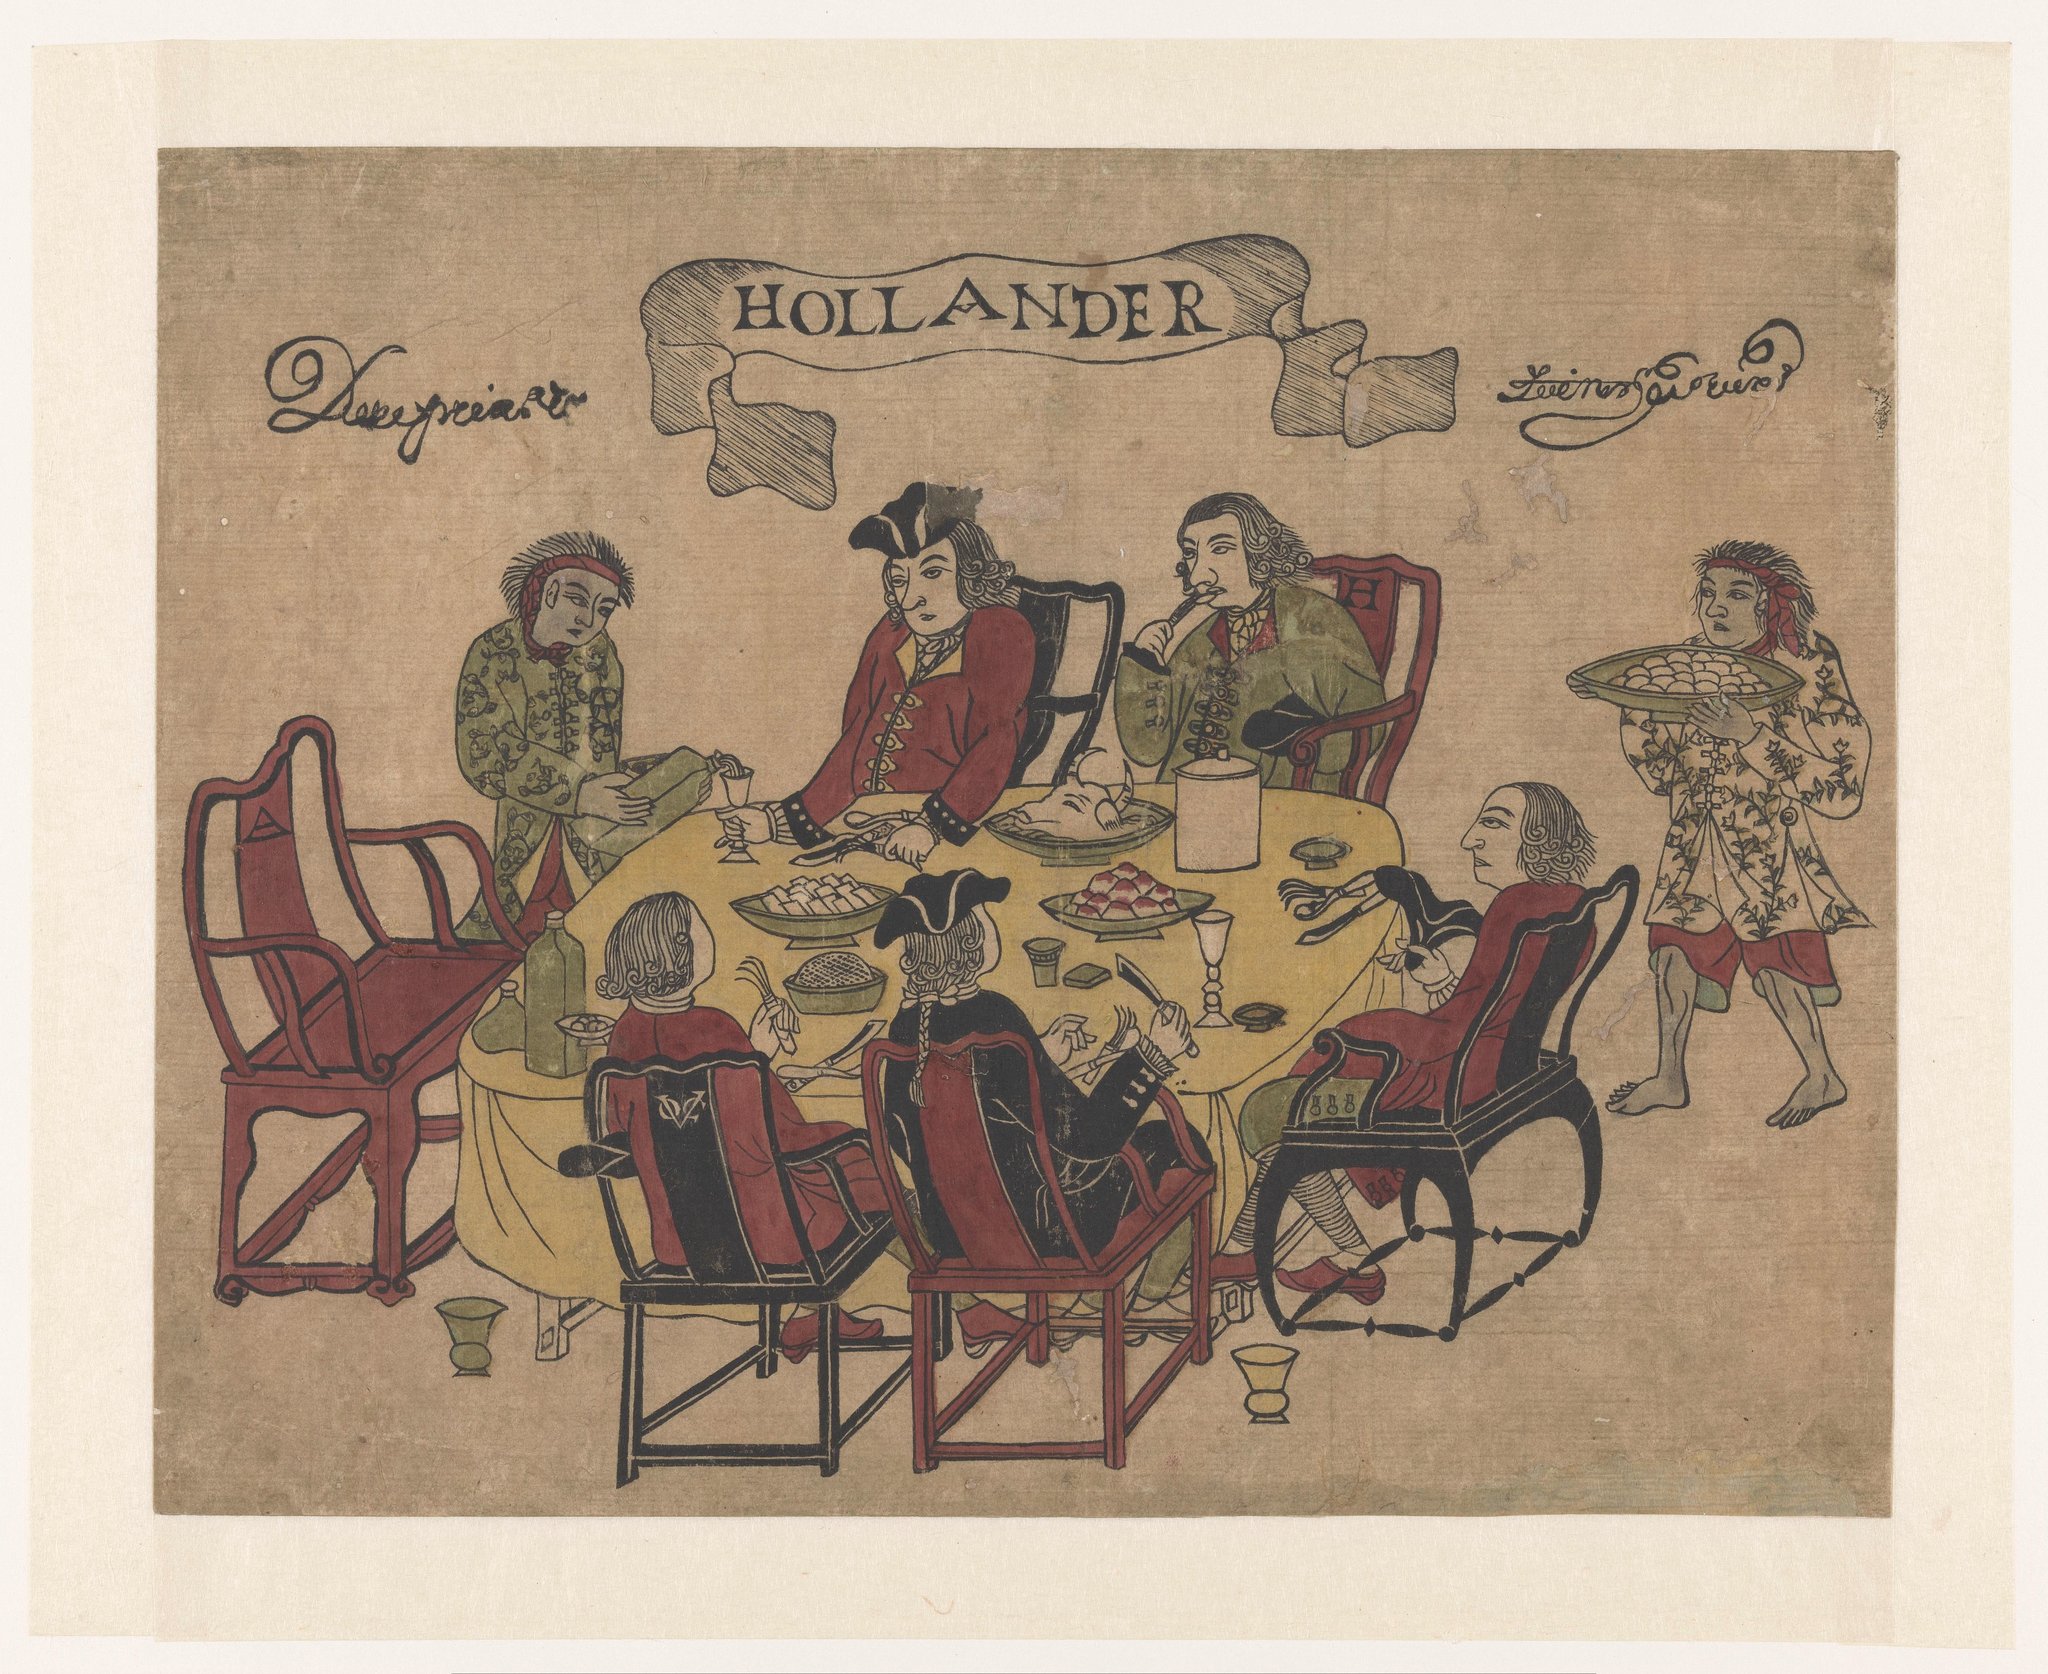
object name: print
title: Five Dutch Men having a Meal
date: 1790-1810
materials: paper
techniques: hand coloring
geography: nagasaki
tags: (family) meal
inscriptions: inscription: ‘Hollander’, inscription: ‘Deze print is zuiver gedruckt.’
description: This print was intended for the tourist market in Nagasaki and illustrates the eating habits of the Dutch on Deshima. Two enslaved men are serving the diners at table, one approaching with a bowl of food, the other pouring gin from a glass bottle. Loosely translated, the text reads ‘This print is a faithful depiction of Dutchmen.’